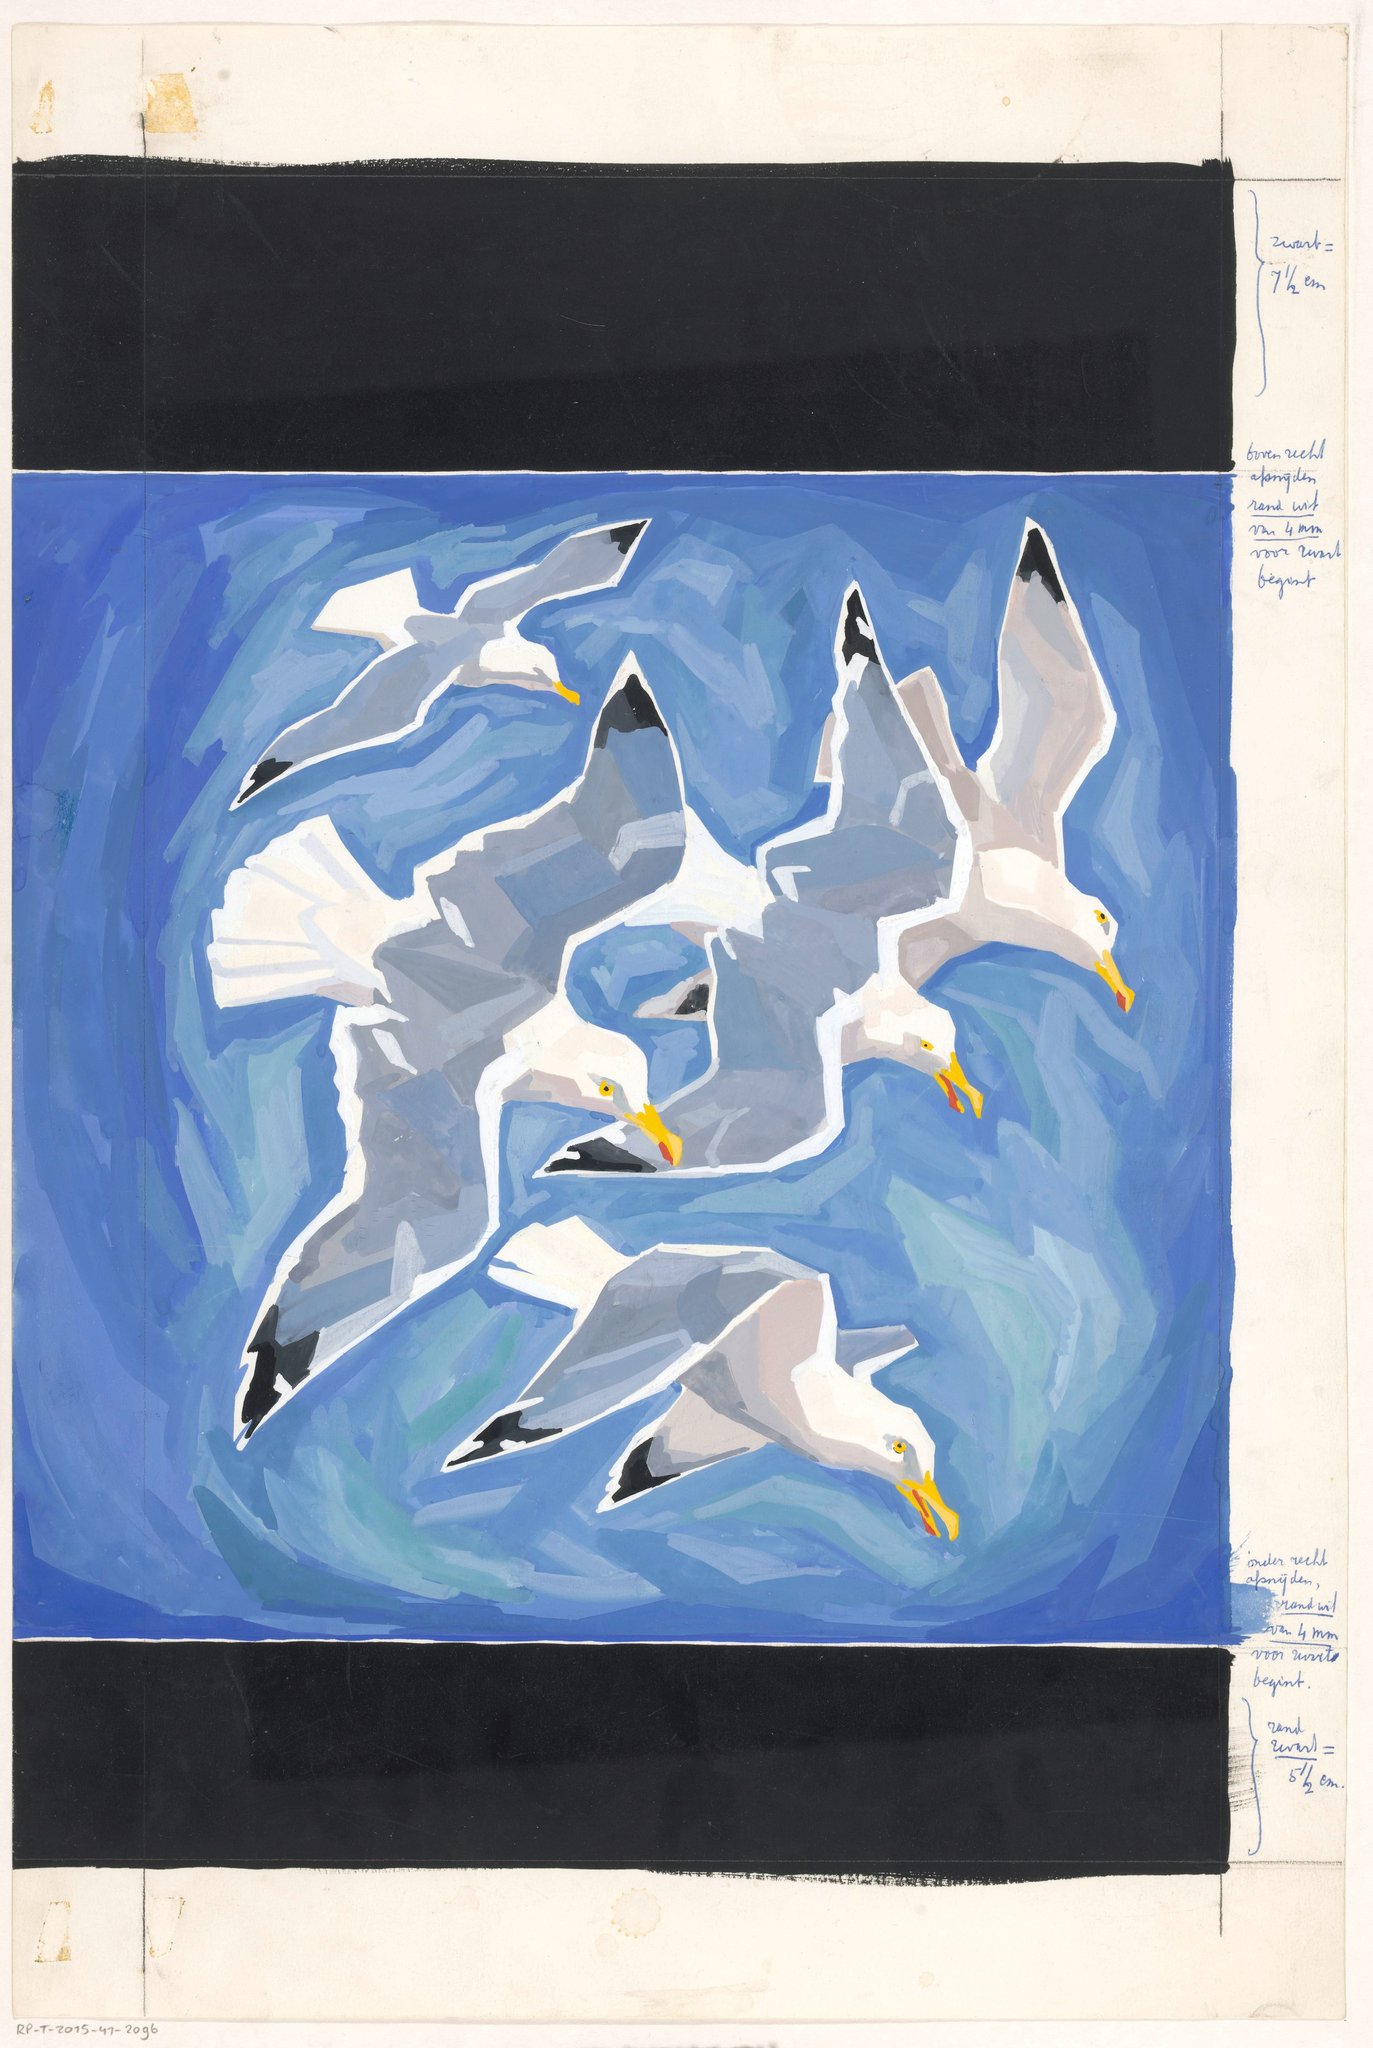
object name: drawing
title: Bandontwerp met vijf vliegende meeuwen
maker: Anonymous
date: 1920-1970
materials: paint, paper, pencil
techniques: brush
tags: shore-birds and wading-birds: gull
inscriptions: collector's mark: Lugt 2228a, :